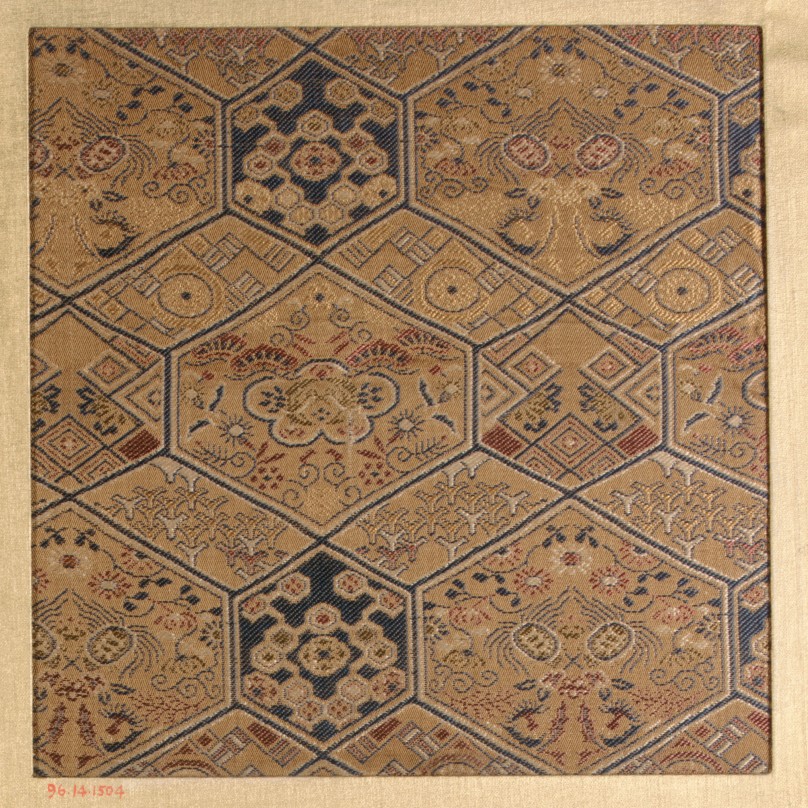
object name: piece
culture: japanese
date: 1701-1900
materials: silk